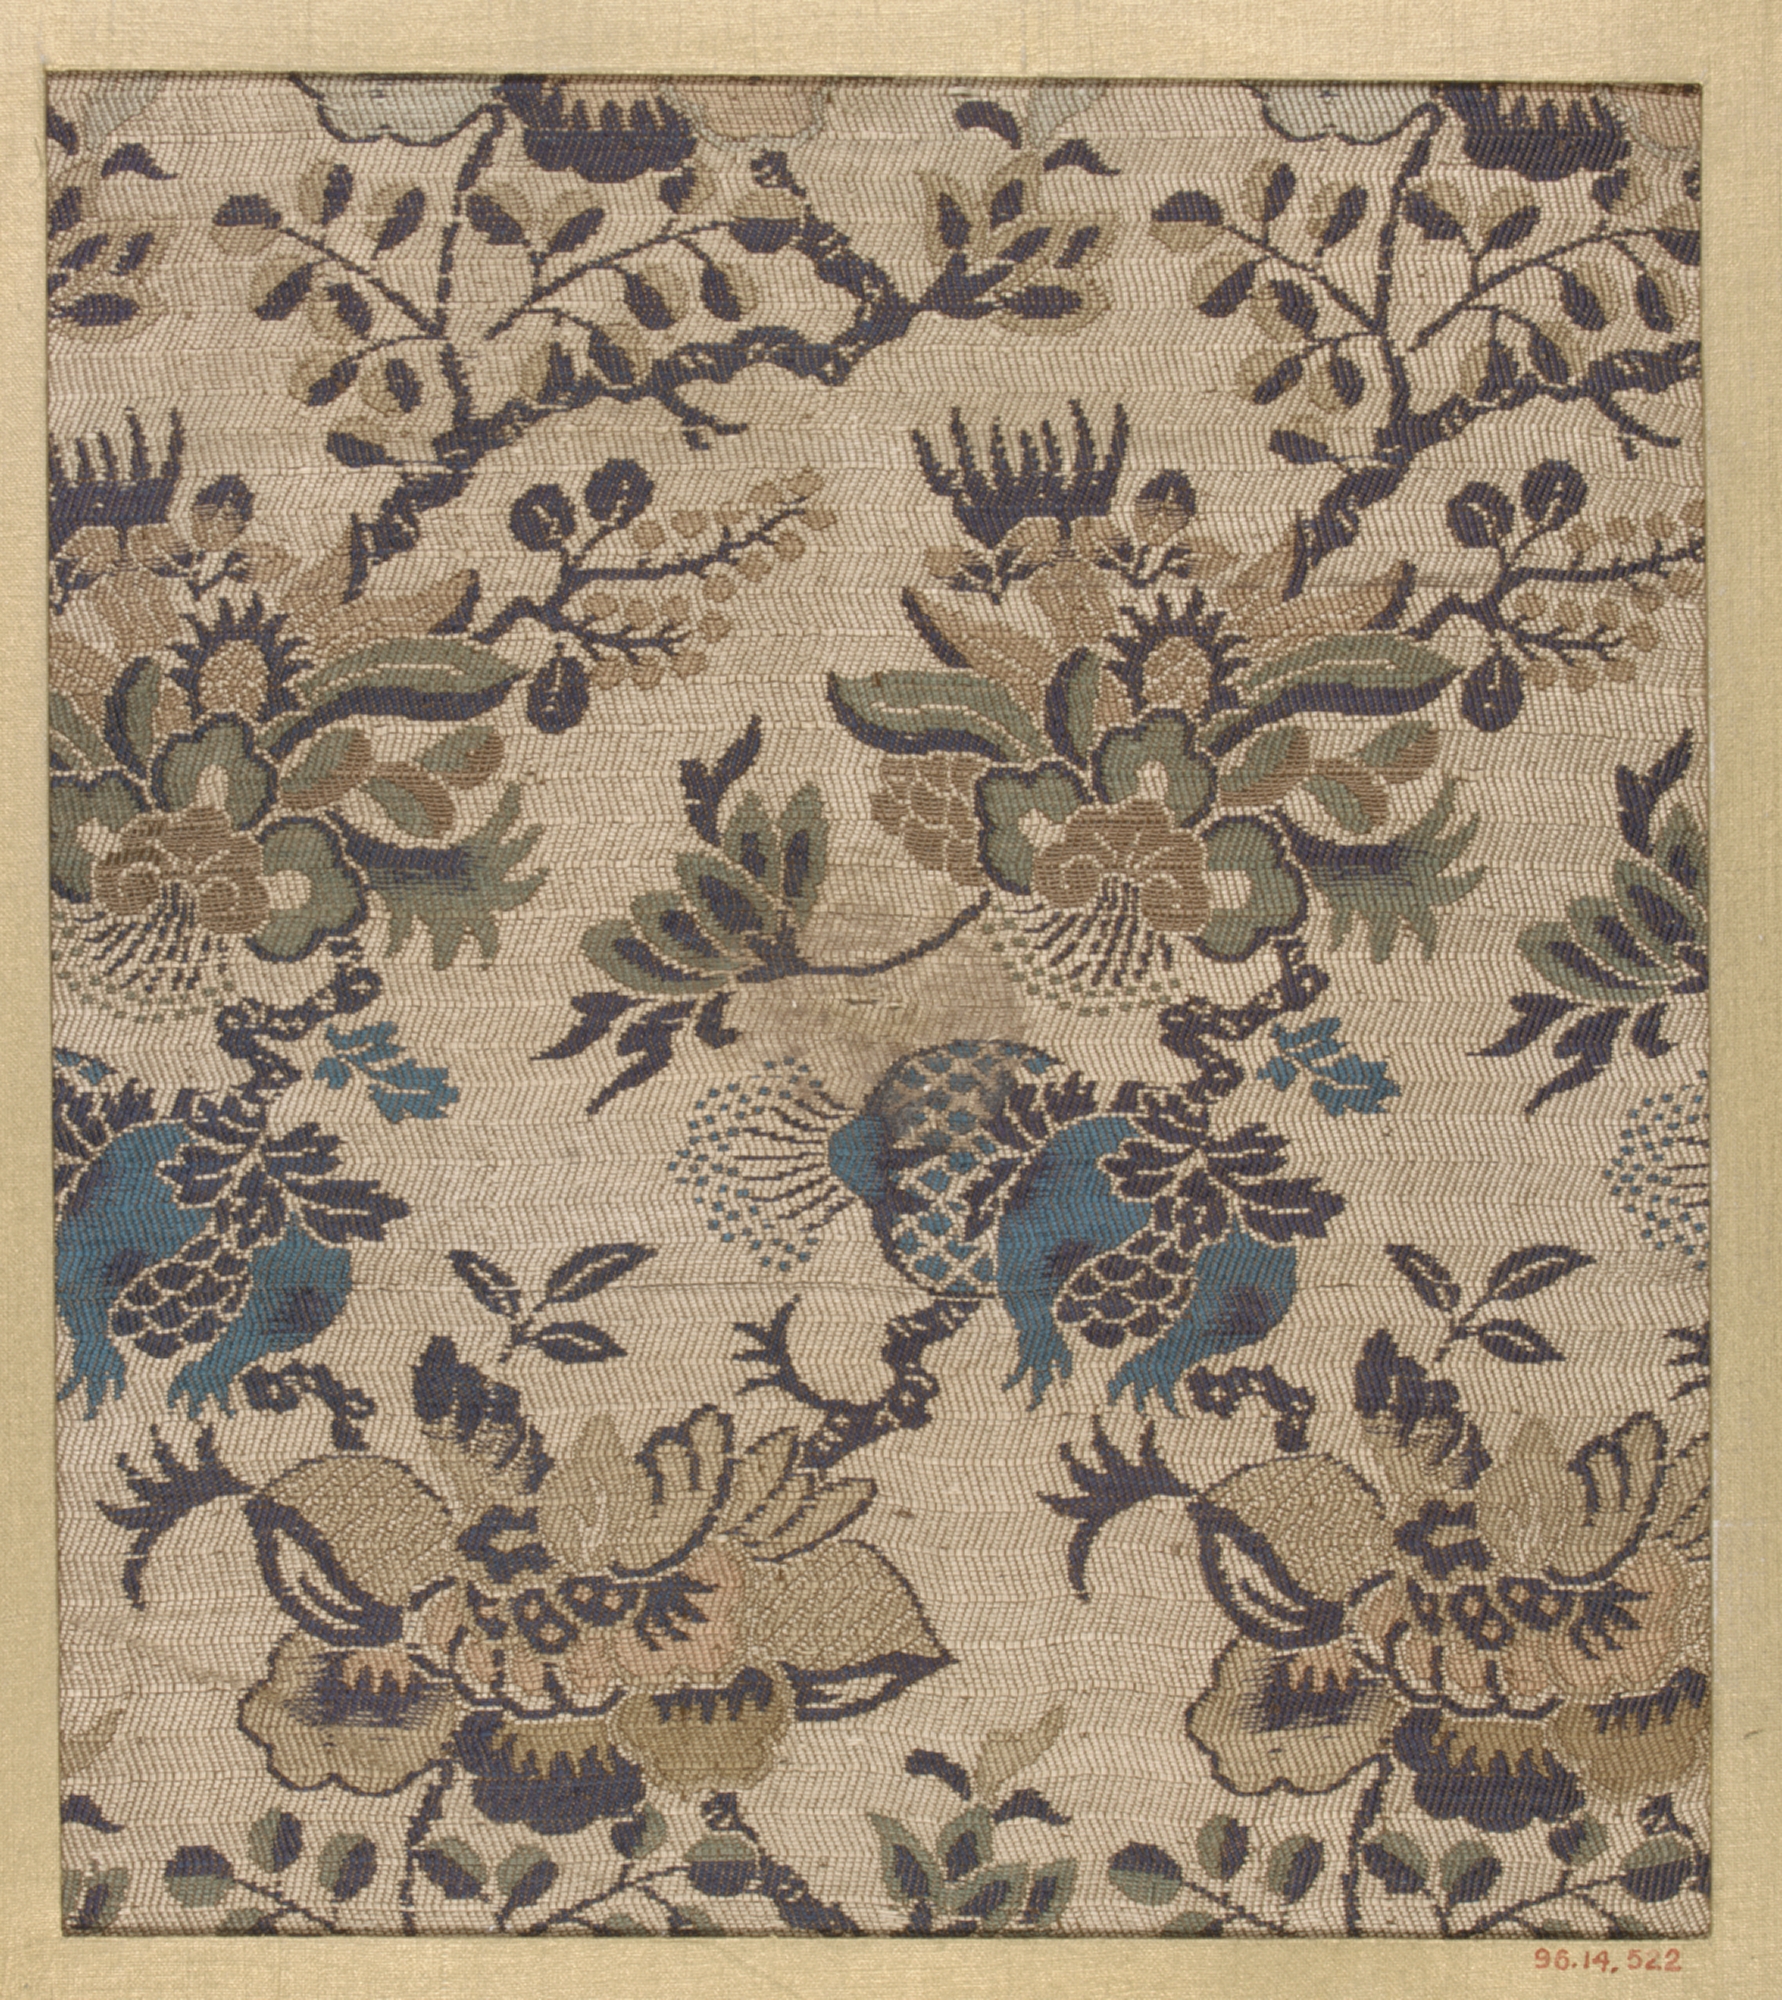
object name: piece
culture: japanese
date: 1701-1900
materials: silk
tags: leaves